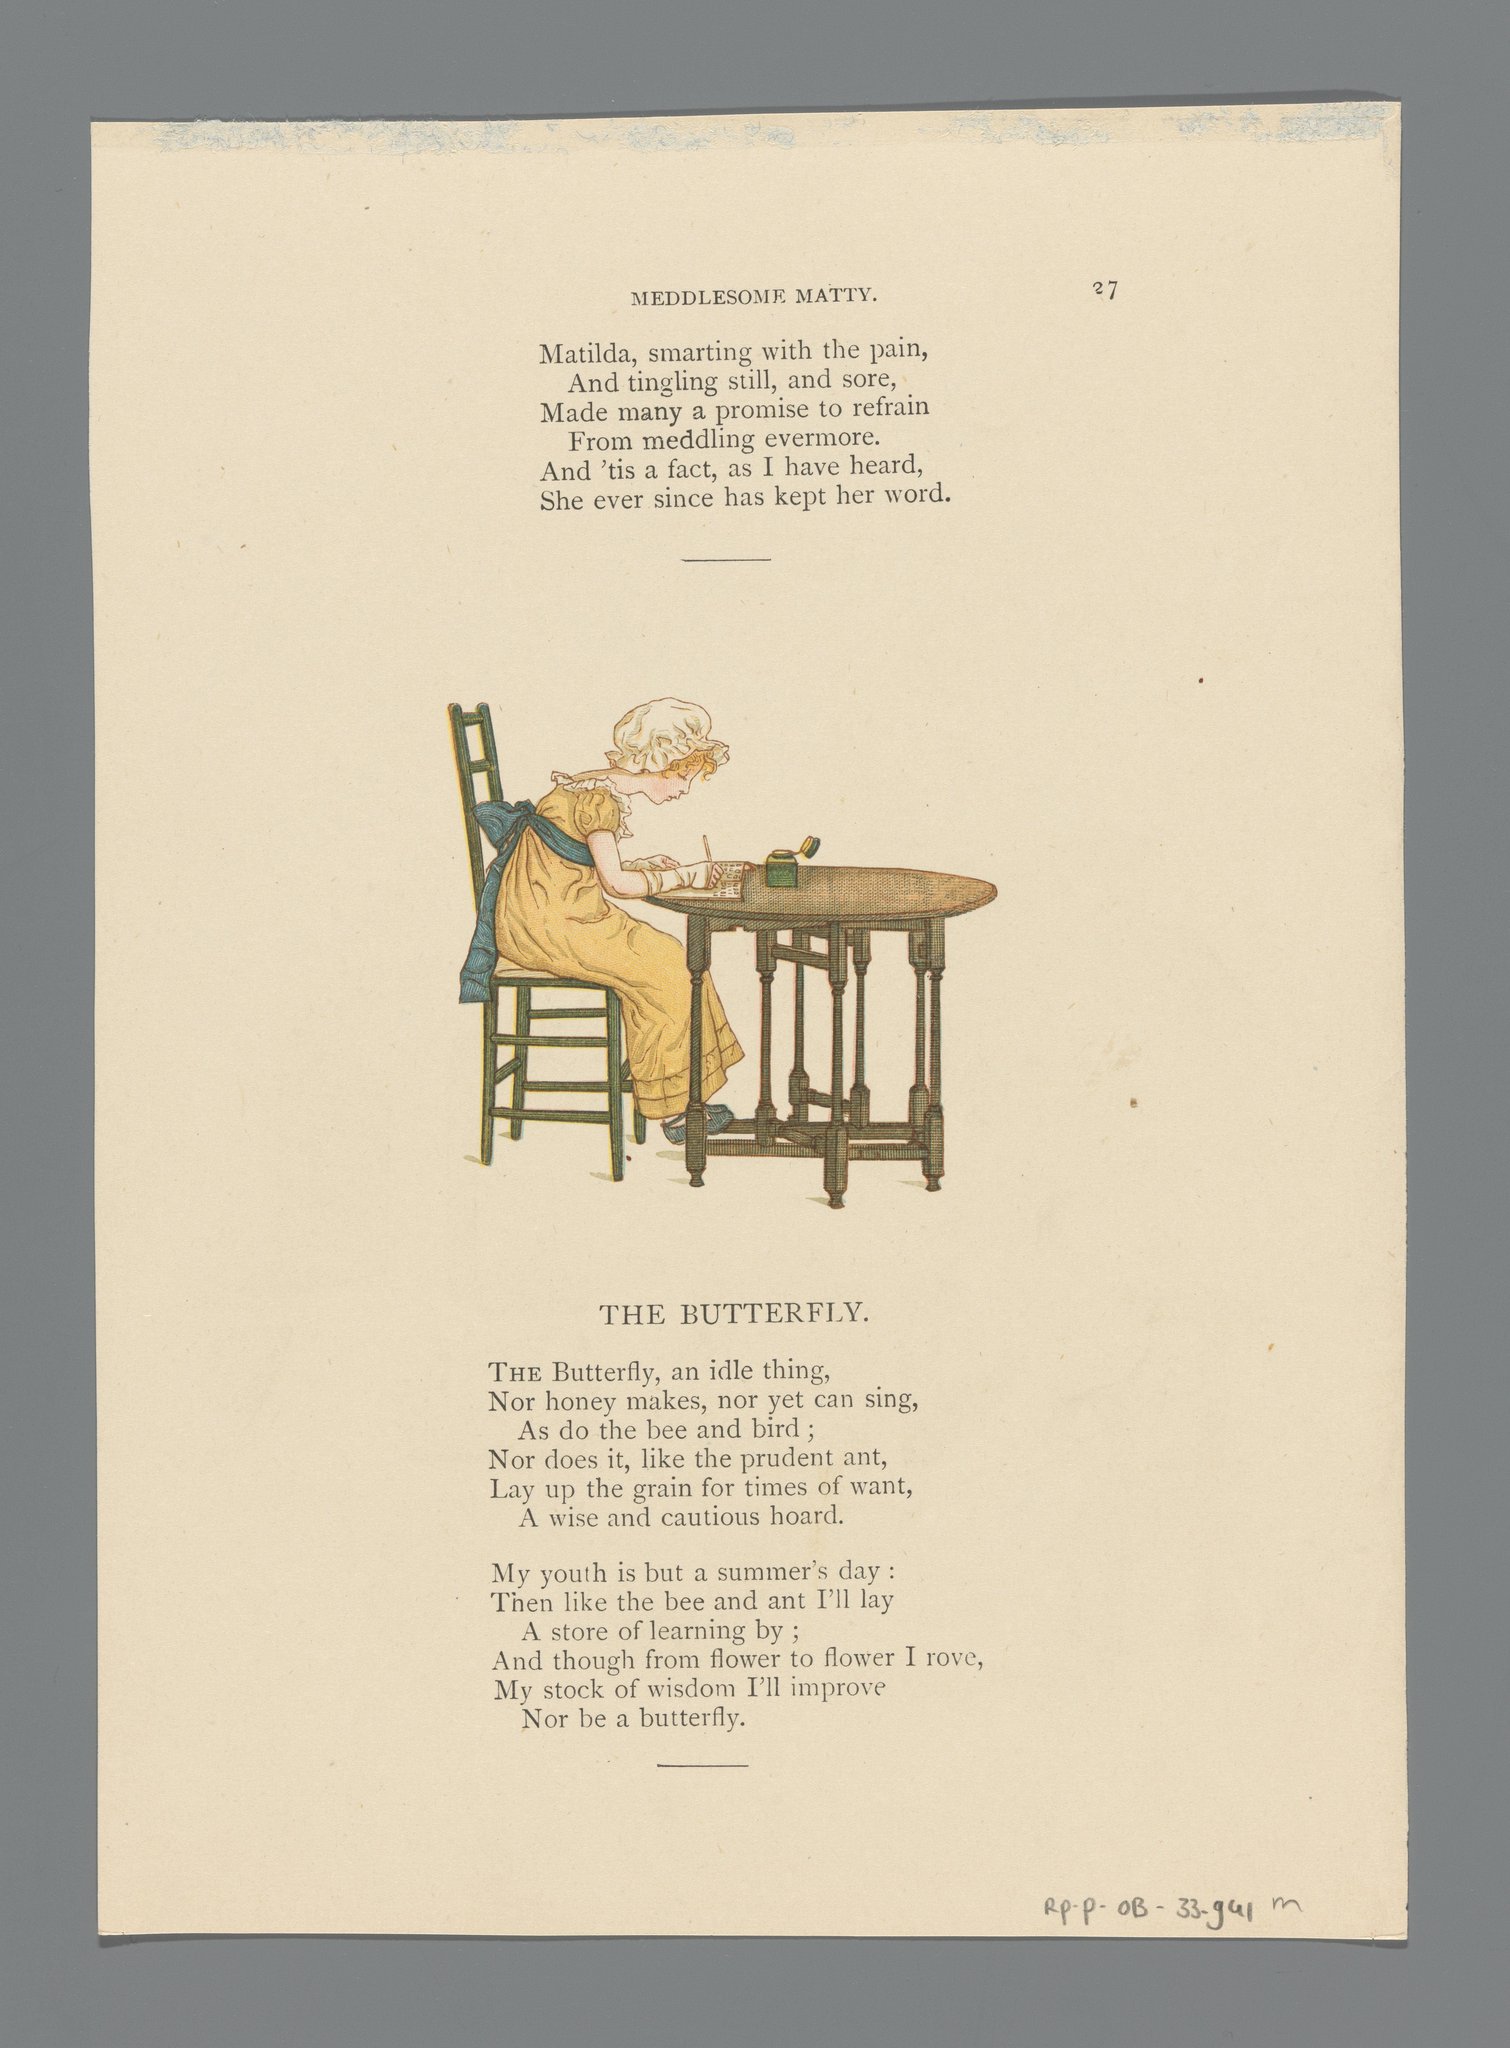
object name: print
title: Meisje aan het schrijven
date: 1883-1927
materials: paper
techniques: wood engraving, letterpress printing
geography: london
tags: girl (child between toddler and youth), writing and letters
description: Prent uit: Jane en Ann Taylor. Little Ann and other poems. Londen: George Routledge & Sons, [1883], p. 27. Of een latere uitgave.